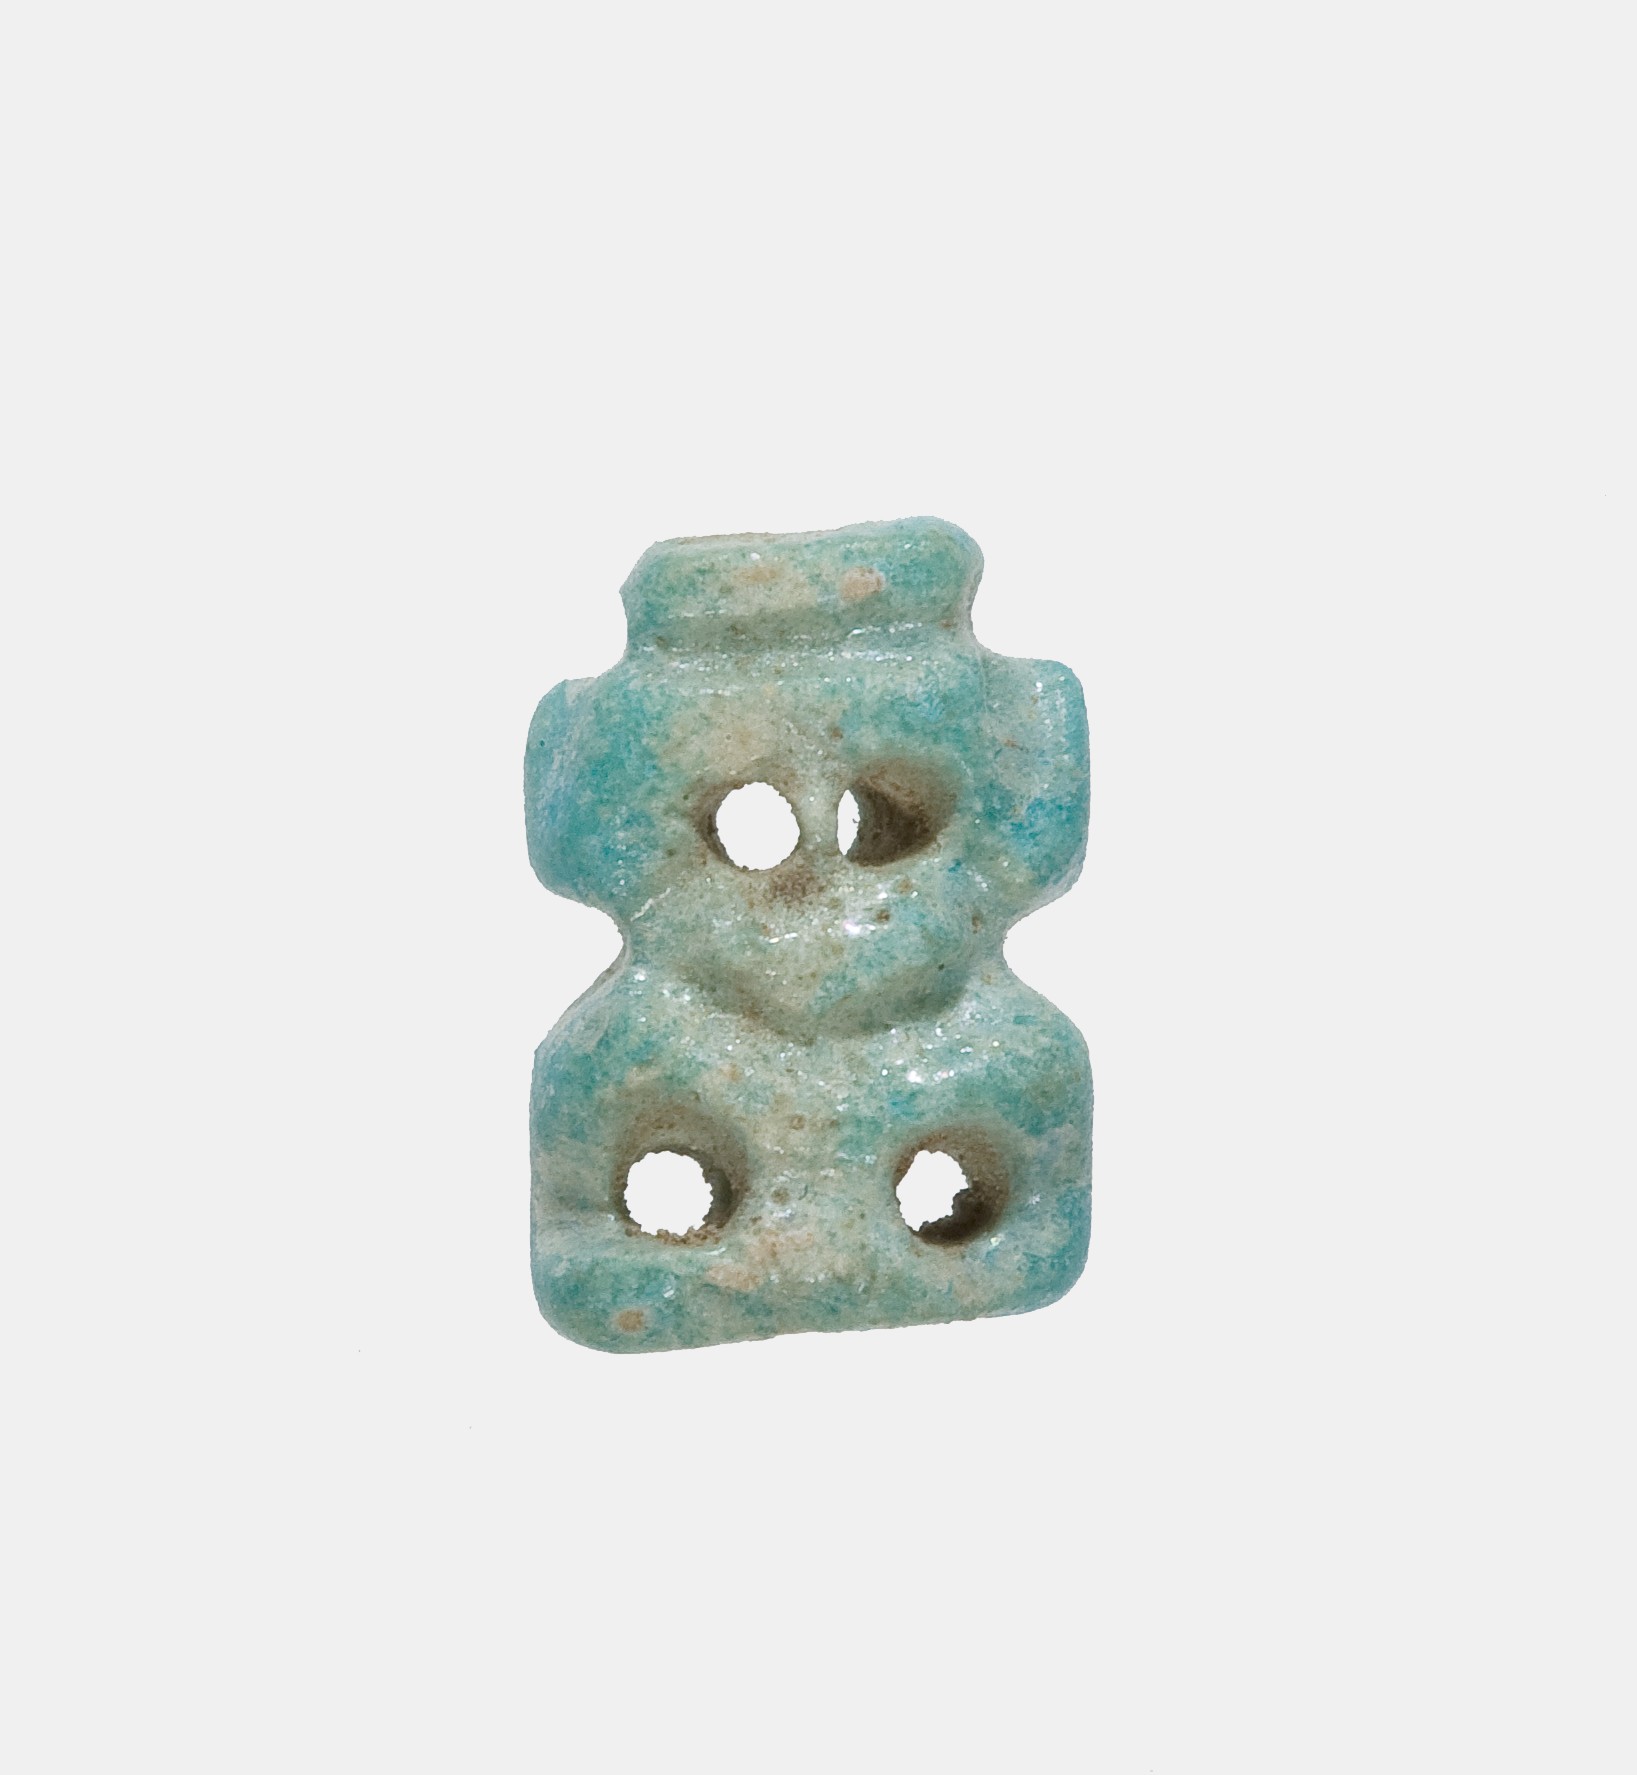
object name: amulet, monkey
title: Monkey Amulet (?)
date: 1802-1450 BCE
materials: faience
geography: egypt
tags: monkeys